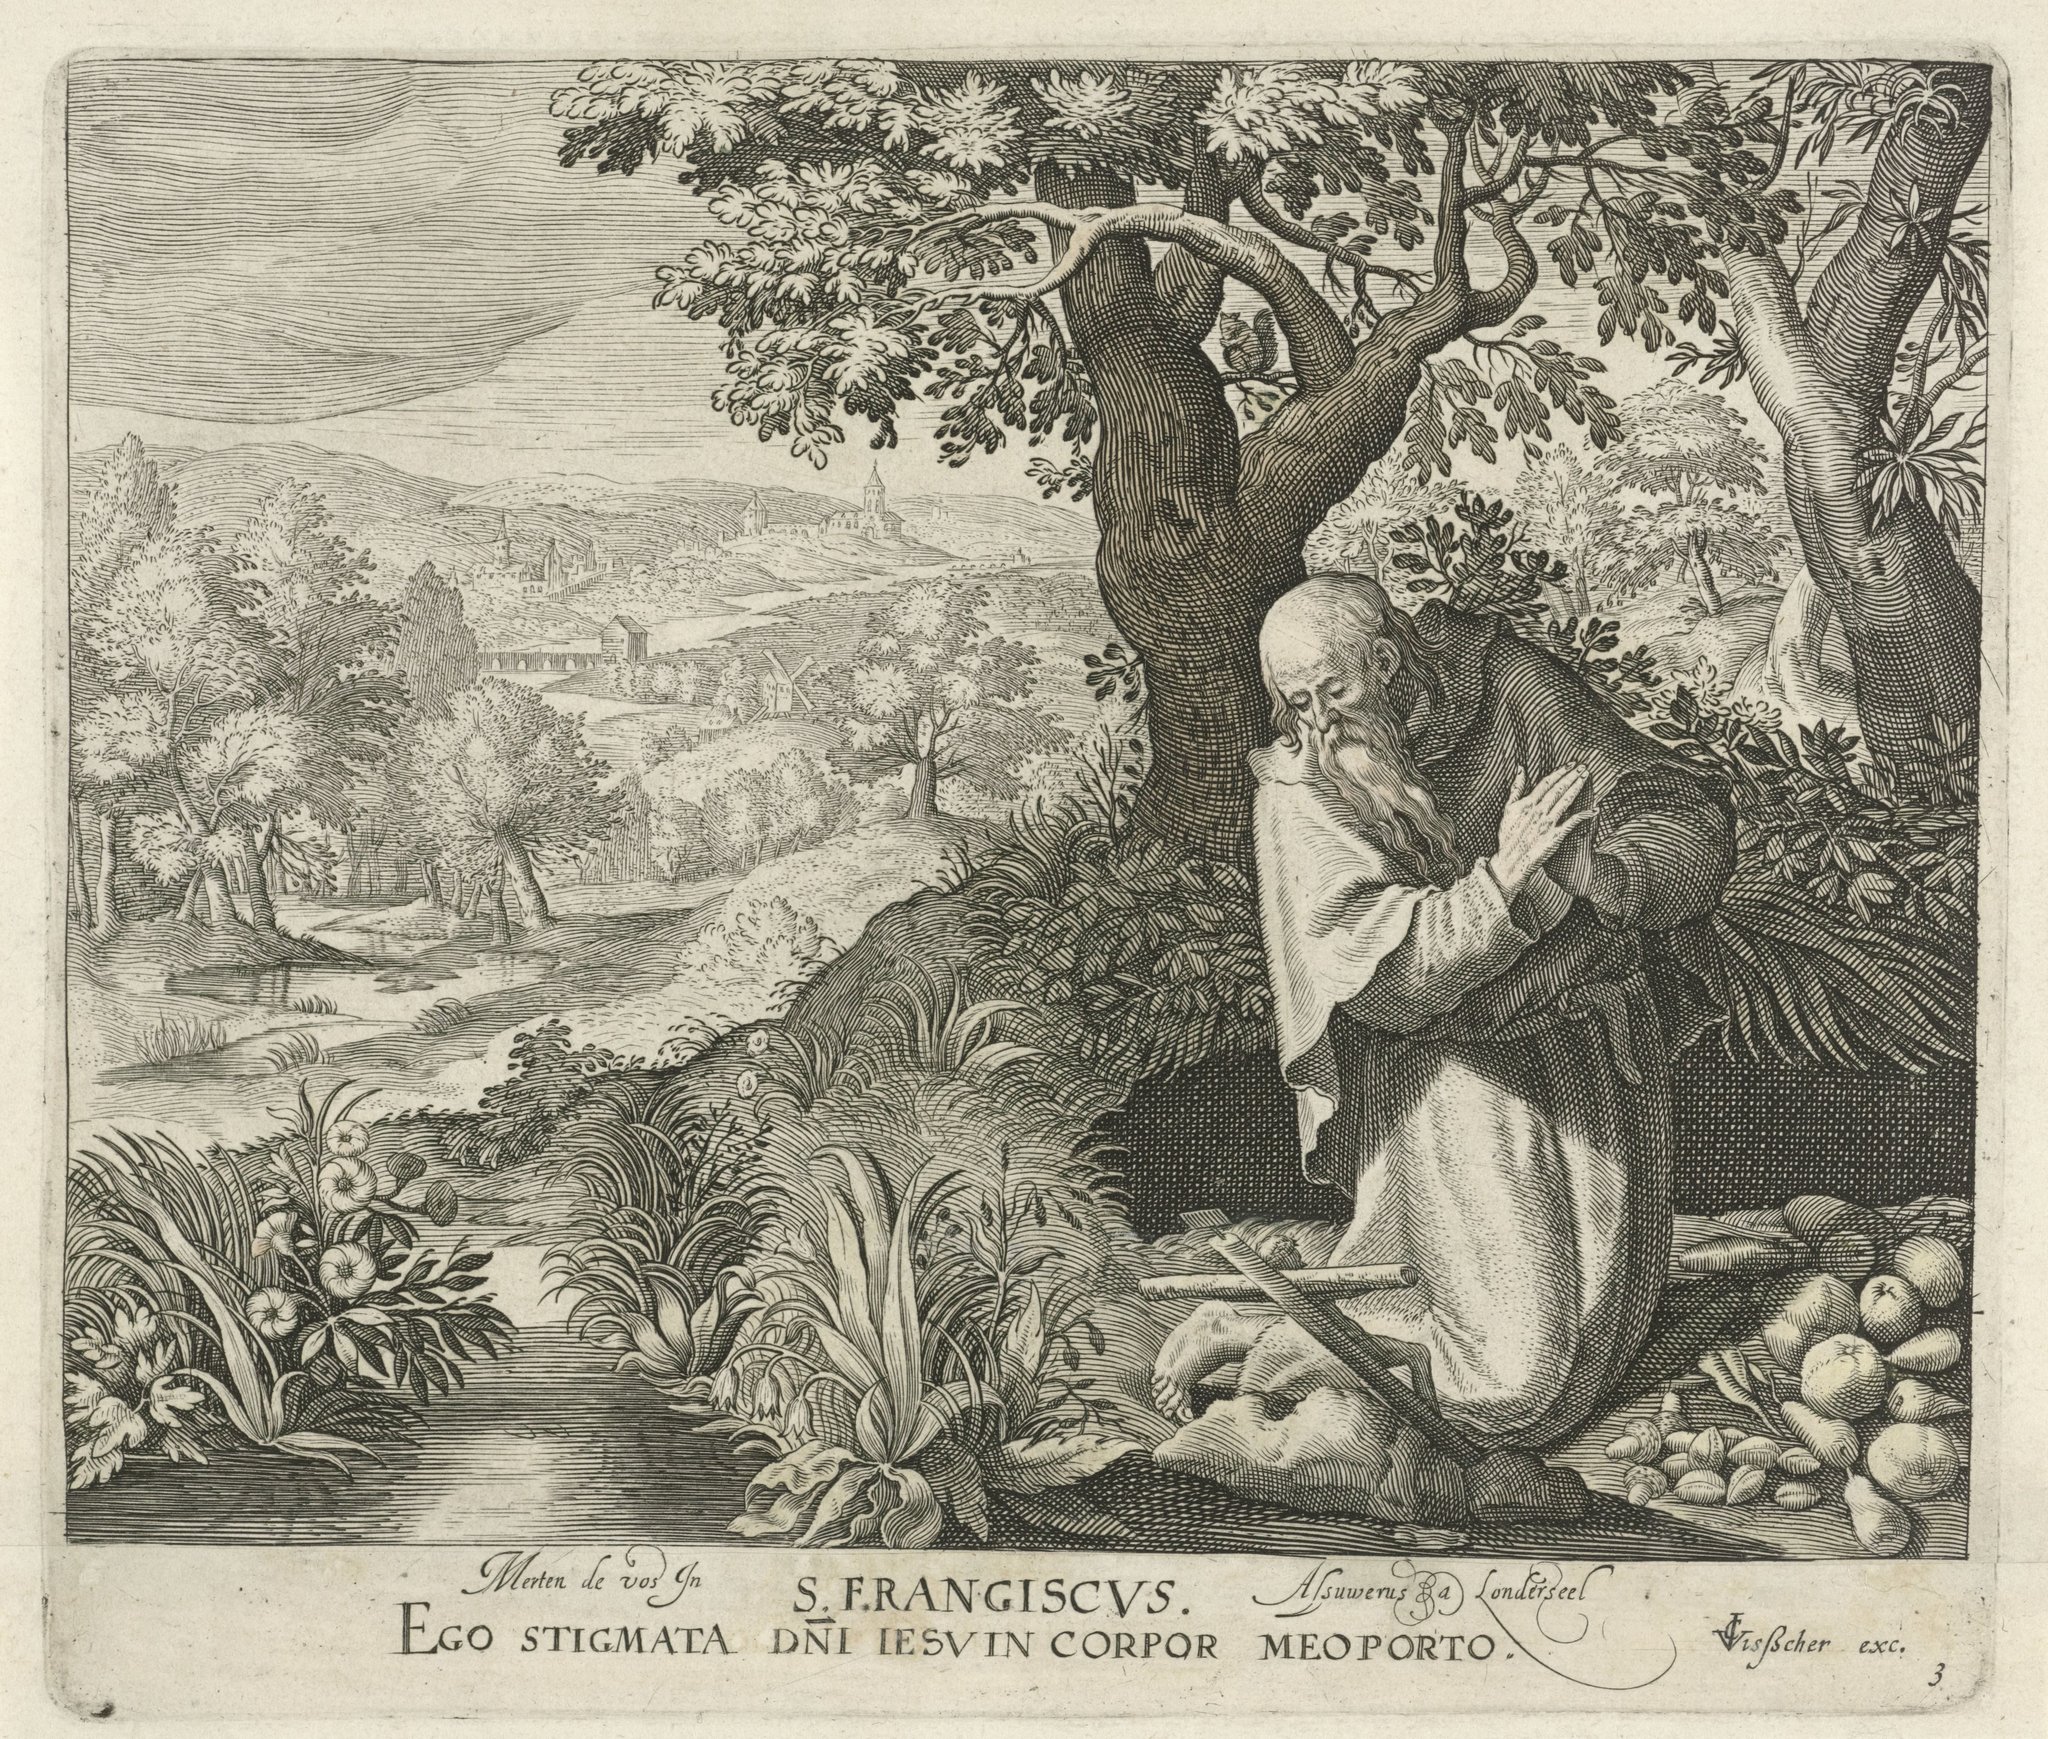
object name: print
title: H. Franciscus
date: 1601-1652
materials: paper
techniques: brush, engraving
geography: amsterdam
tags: founder of the order of friars minor (franciscans), francis(cus) of assisi; possible attributes: book, crucifix, lily, skull, stigmata, anchorite, hermit, meditation over skull and/or crucifix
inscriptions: collector's mark: Lugt 2228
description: De heilige Franciscus, als kluizenaar teruggetrokken in het bos. Hij knielt met gevouwen handen voor een crucifix. In de marge een onderschrift in Latijn.